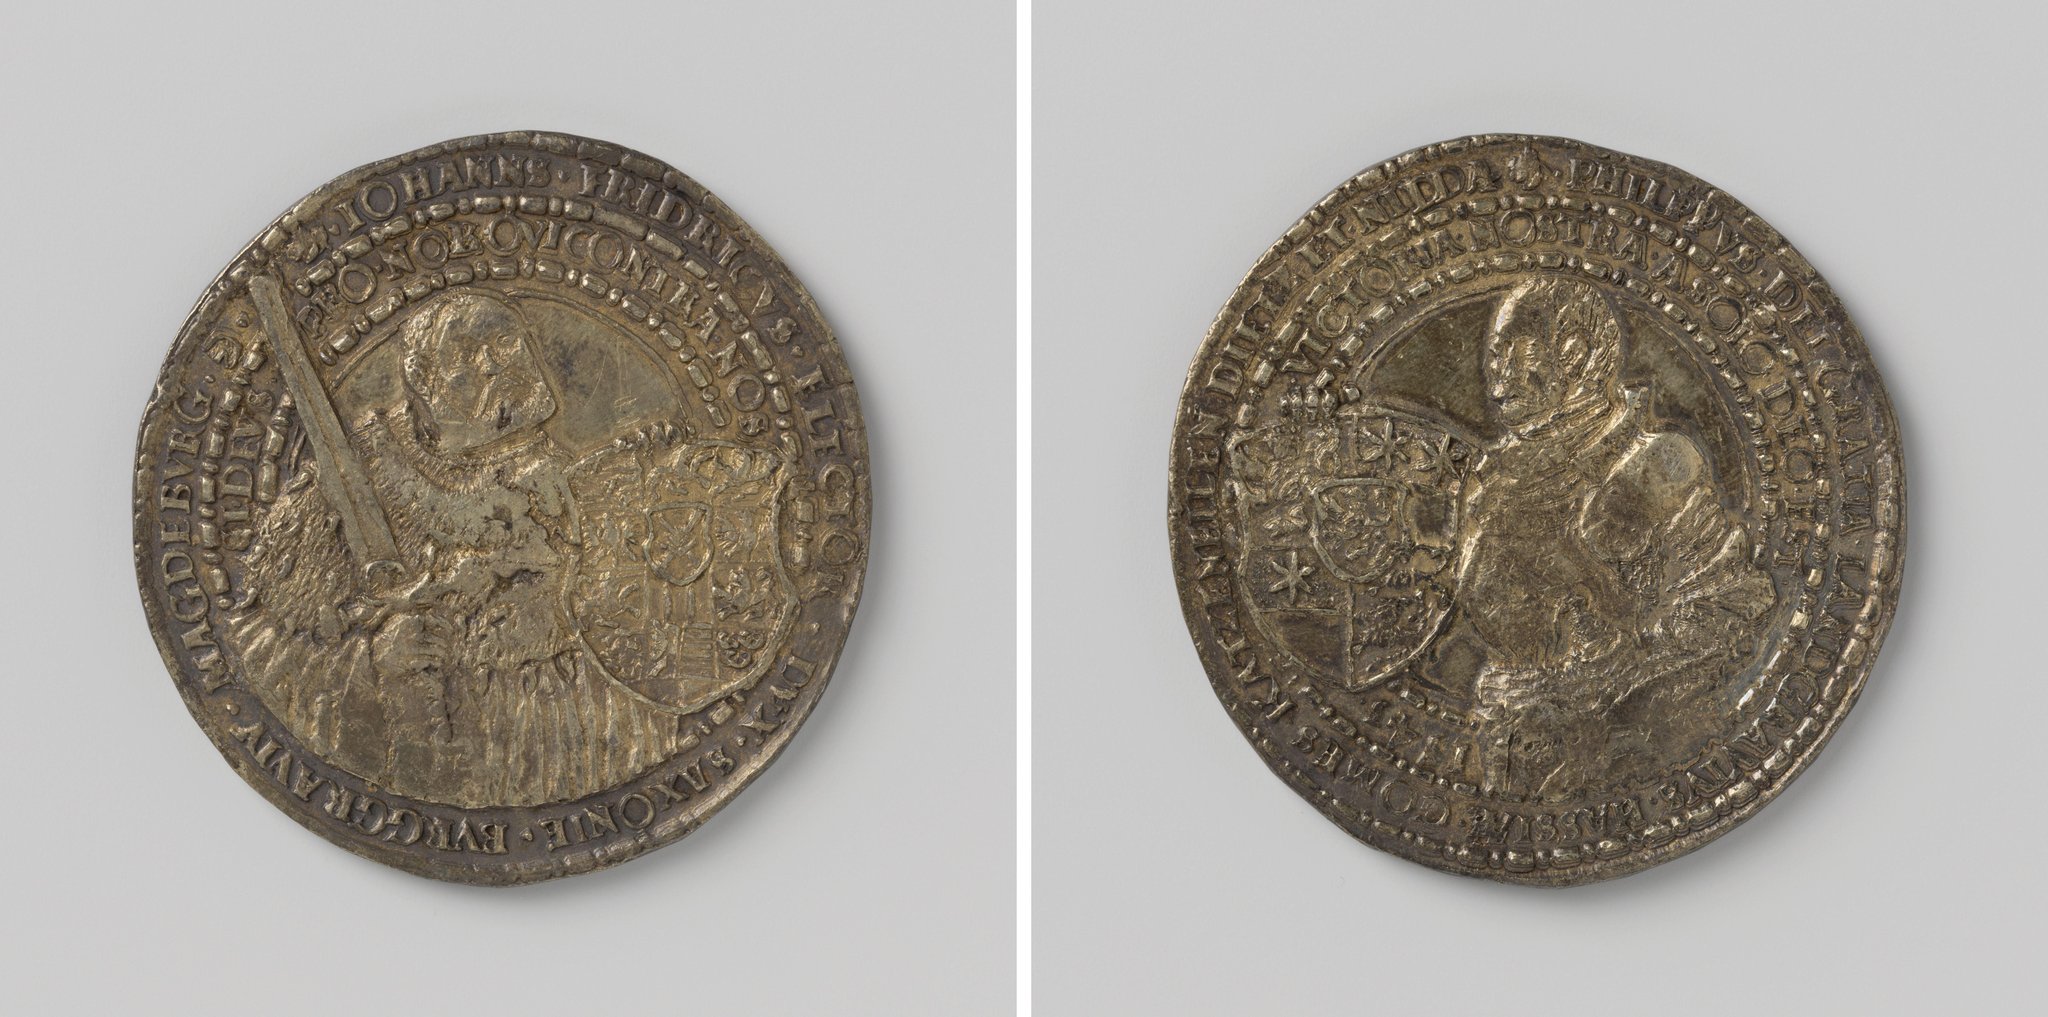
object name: history medal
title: Johan Frederik de Grootmoedige, keurvorst van Saksen en Filips de Grootmoedige, landgraaf van Hessen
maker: Anonymous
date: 1543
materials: silver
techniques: gilding, striking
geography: germany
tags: philip i (landgrave of hesse)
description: Zilveren penning. Voorzijde: borststuk man met zwaard op schouder en wapenschild in hand binnen tweeregelig omschrift. Keerzijde: borststuk man wapenschild in zijn rechterhand en met andere hand op zwaard binnen tweeregelig omschrift